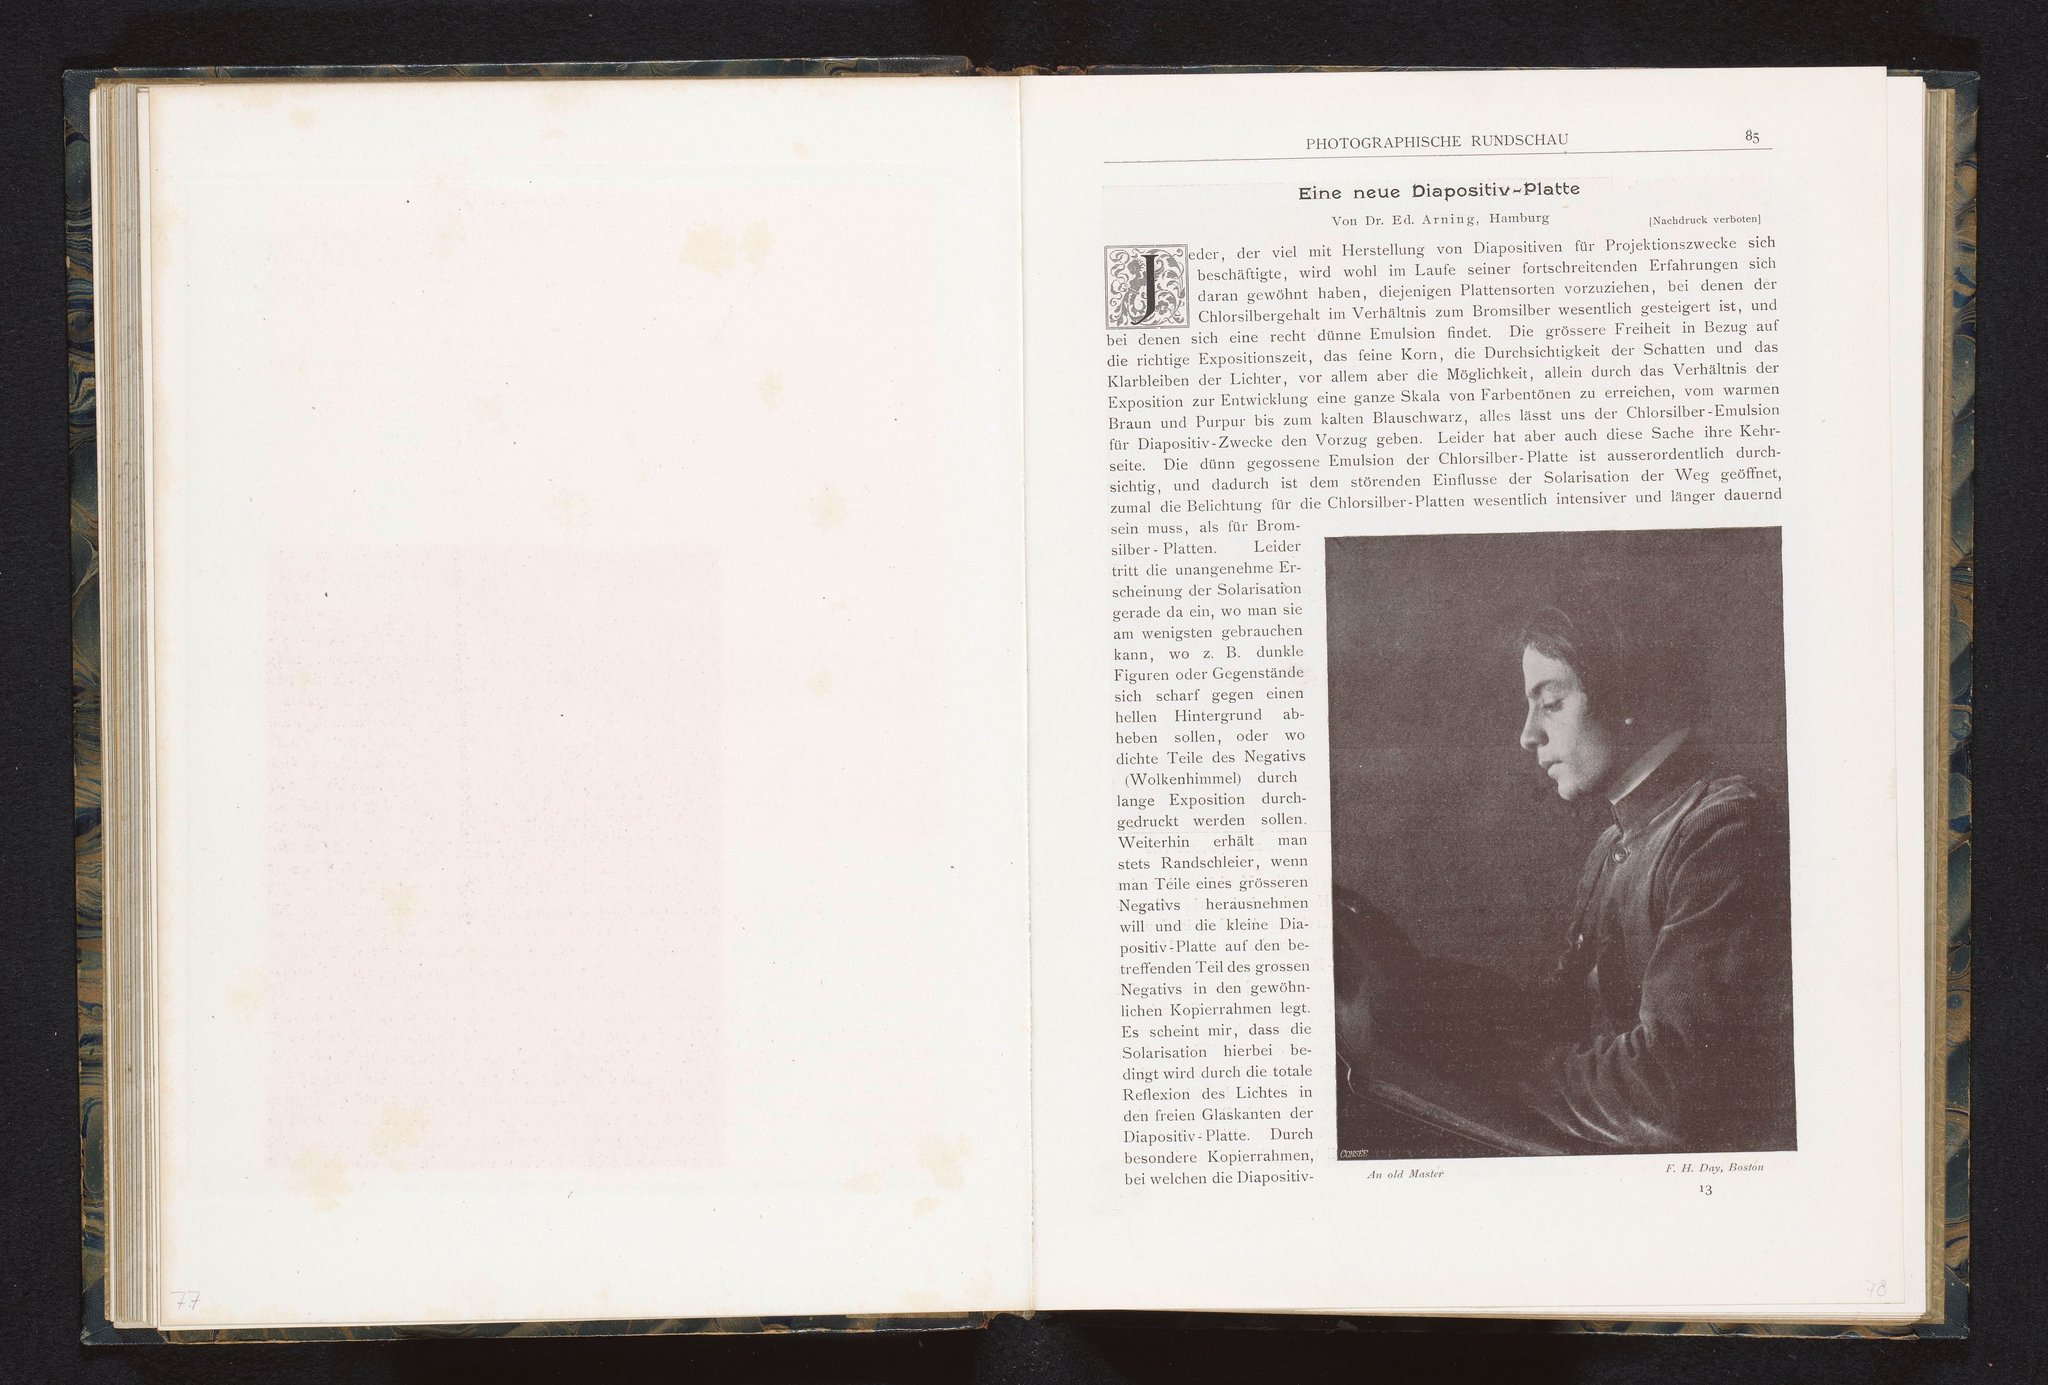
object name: page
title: Portret van een onbekend persoon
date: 1895-1900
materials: paper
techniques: autotype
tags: historical persons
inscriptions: monogram: ‘Consée’